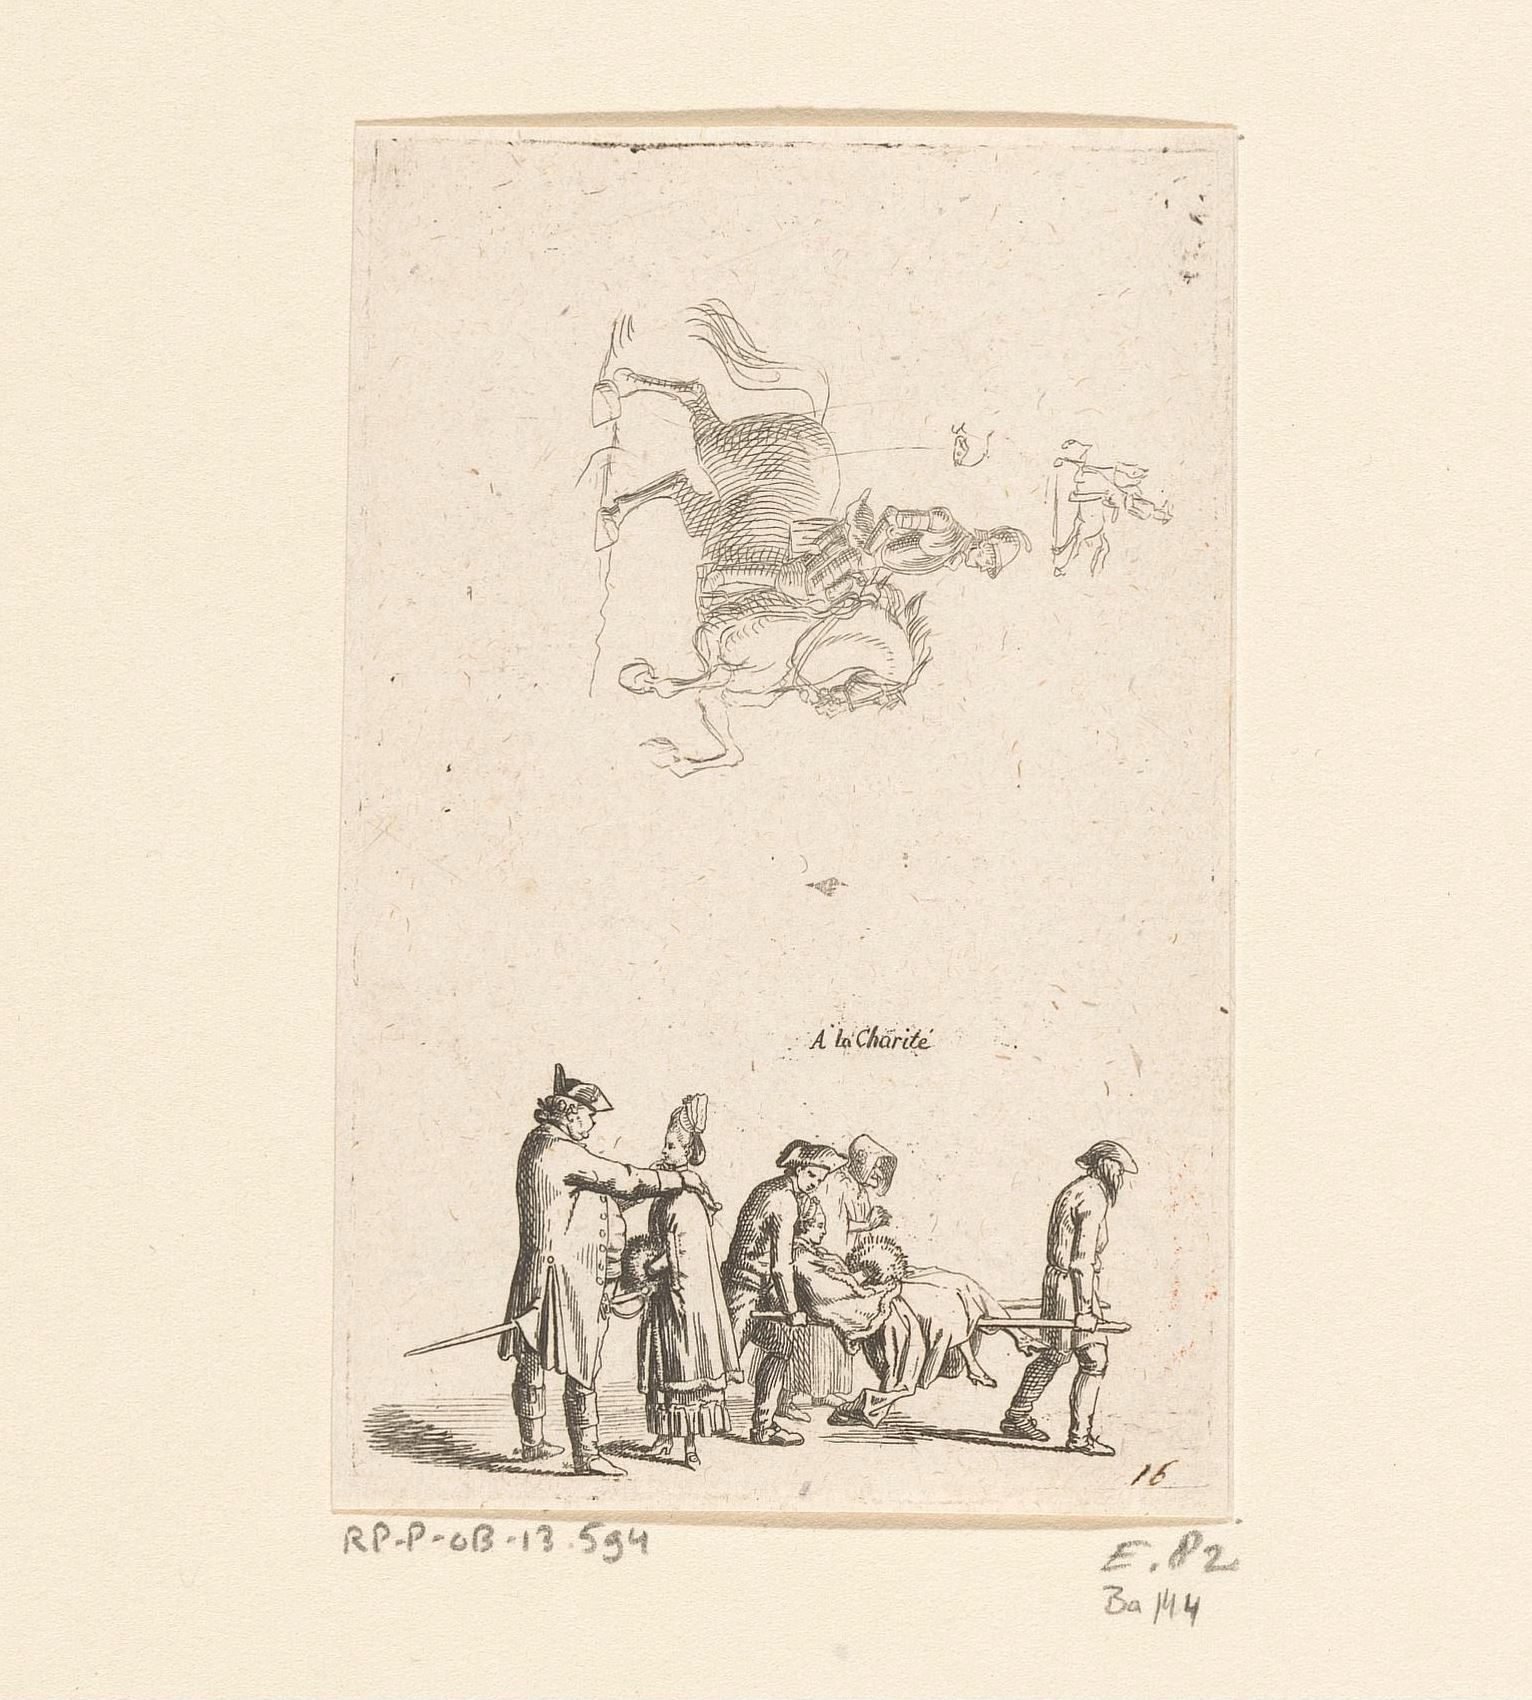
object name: print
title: Scène in het Berlijnse ziekenhuis Charité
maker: daniel nikolaus chodowiecki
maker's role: draughtsman, print maker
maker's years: 1726-1801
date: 1736-1801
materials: paper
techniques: etching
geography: berlin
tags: riding a horse, ass, or mule; rider, horseman, (carrying a person on a) litter, stretcher, muff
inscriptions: inscription: ‘16’, collector's mark: Lugt 240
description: Links is een jonge vrouw met een mof in gesprek met een dikke officier die zijn handen op haar schouders heeft gelegd. Rechts wordt dezelfde vrouw weggedragen op een brancard. Boven een geharnaste man te paard en een schets van een ruiter.